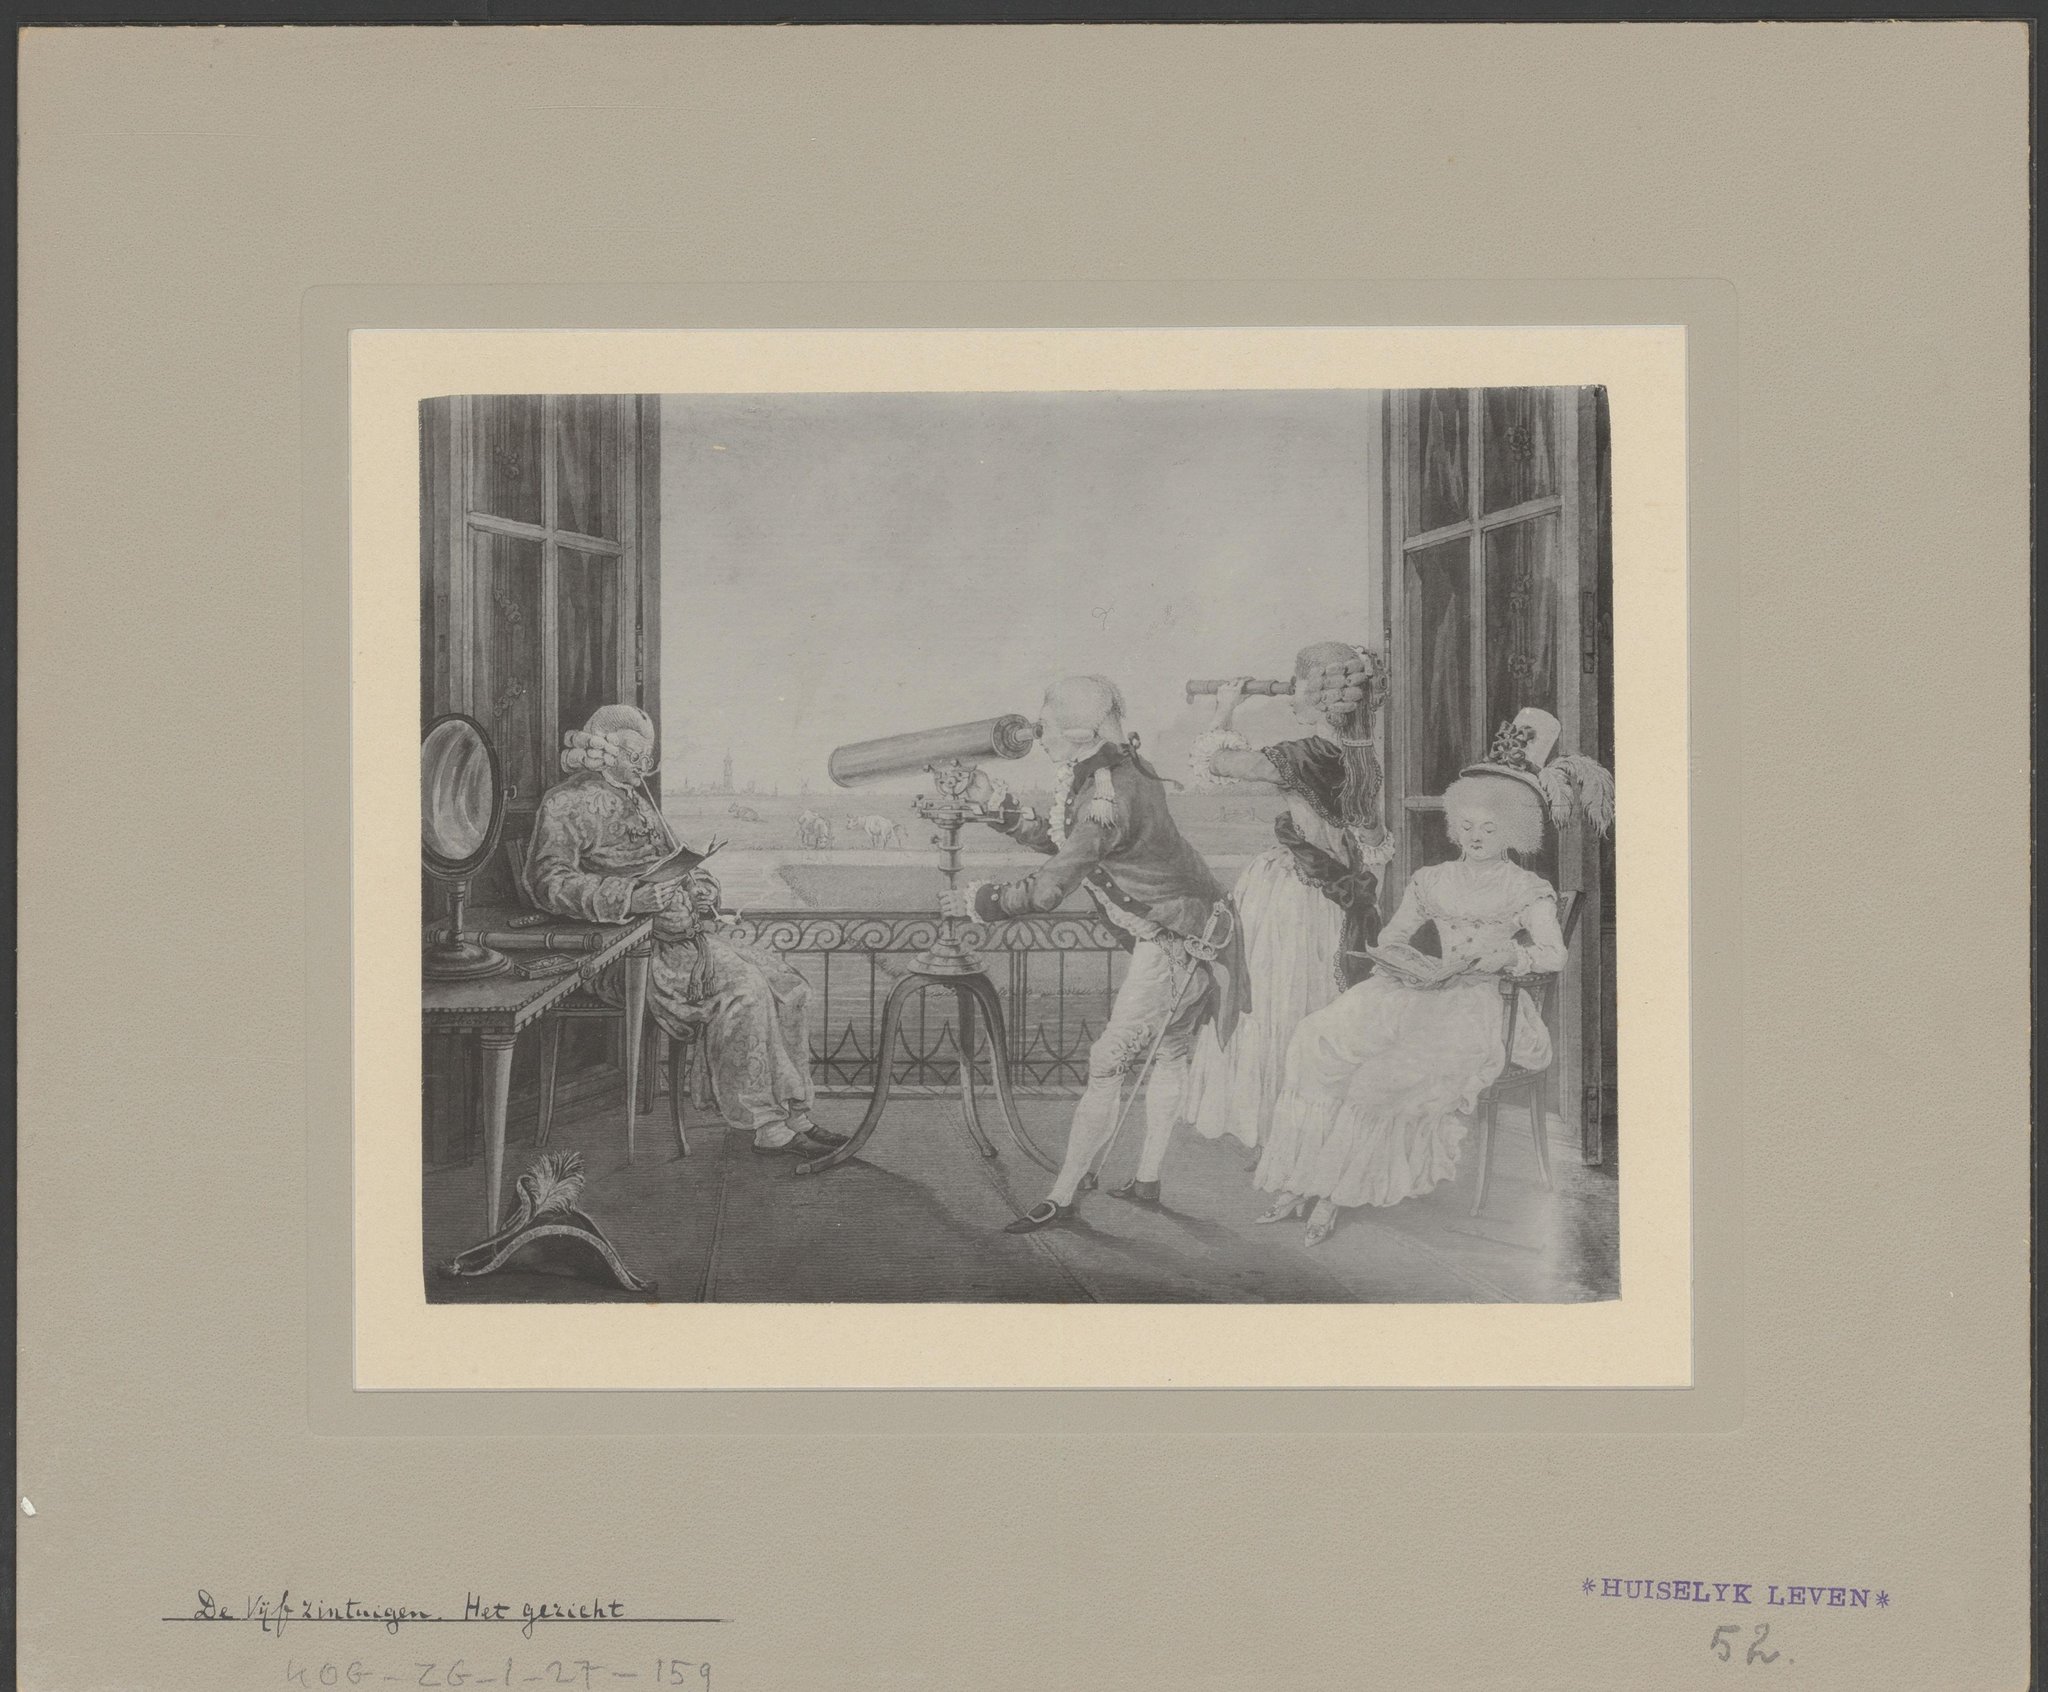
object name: reproduction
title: Fotoreproducties van tekeningen van de vijf zintuigen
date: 1881-1903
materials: cardboard, photographic support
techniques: gelatin silver print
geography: amsterdam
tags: reading, sight, looking (one of the five senses), family life at home, telescope, binoculars, spy-glass, etc.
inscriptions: collector's mark, collector's mark: Lugt 1641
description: Volgens het inventarisboek bevonden de tekeningen zich in 1914 in het bezit van mevr. de wed. de Bont, in de Vondelstraat te Amsterdam, waar de foto's in opdracht van dhr. Dr. A.G.C. de Vries zijn gemaakt.